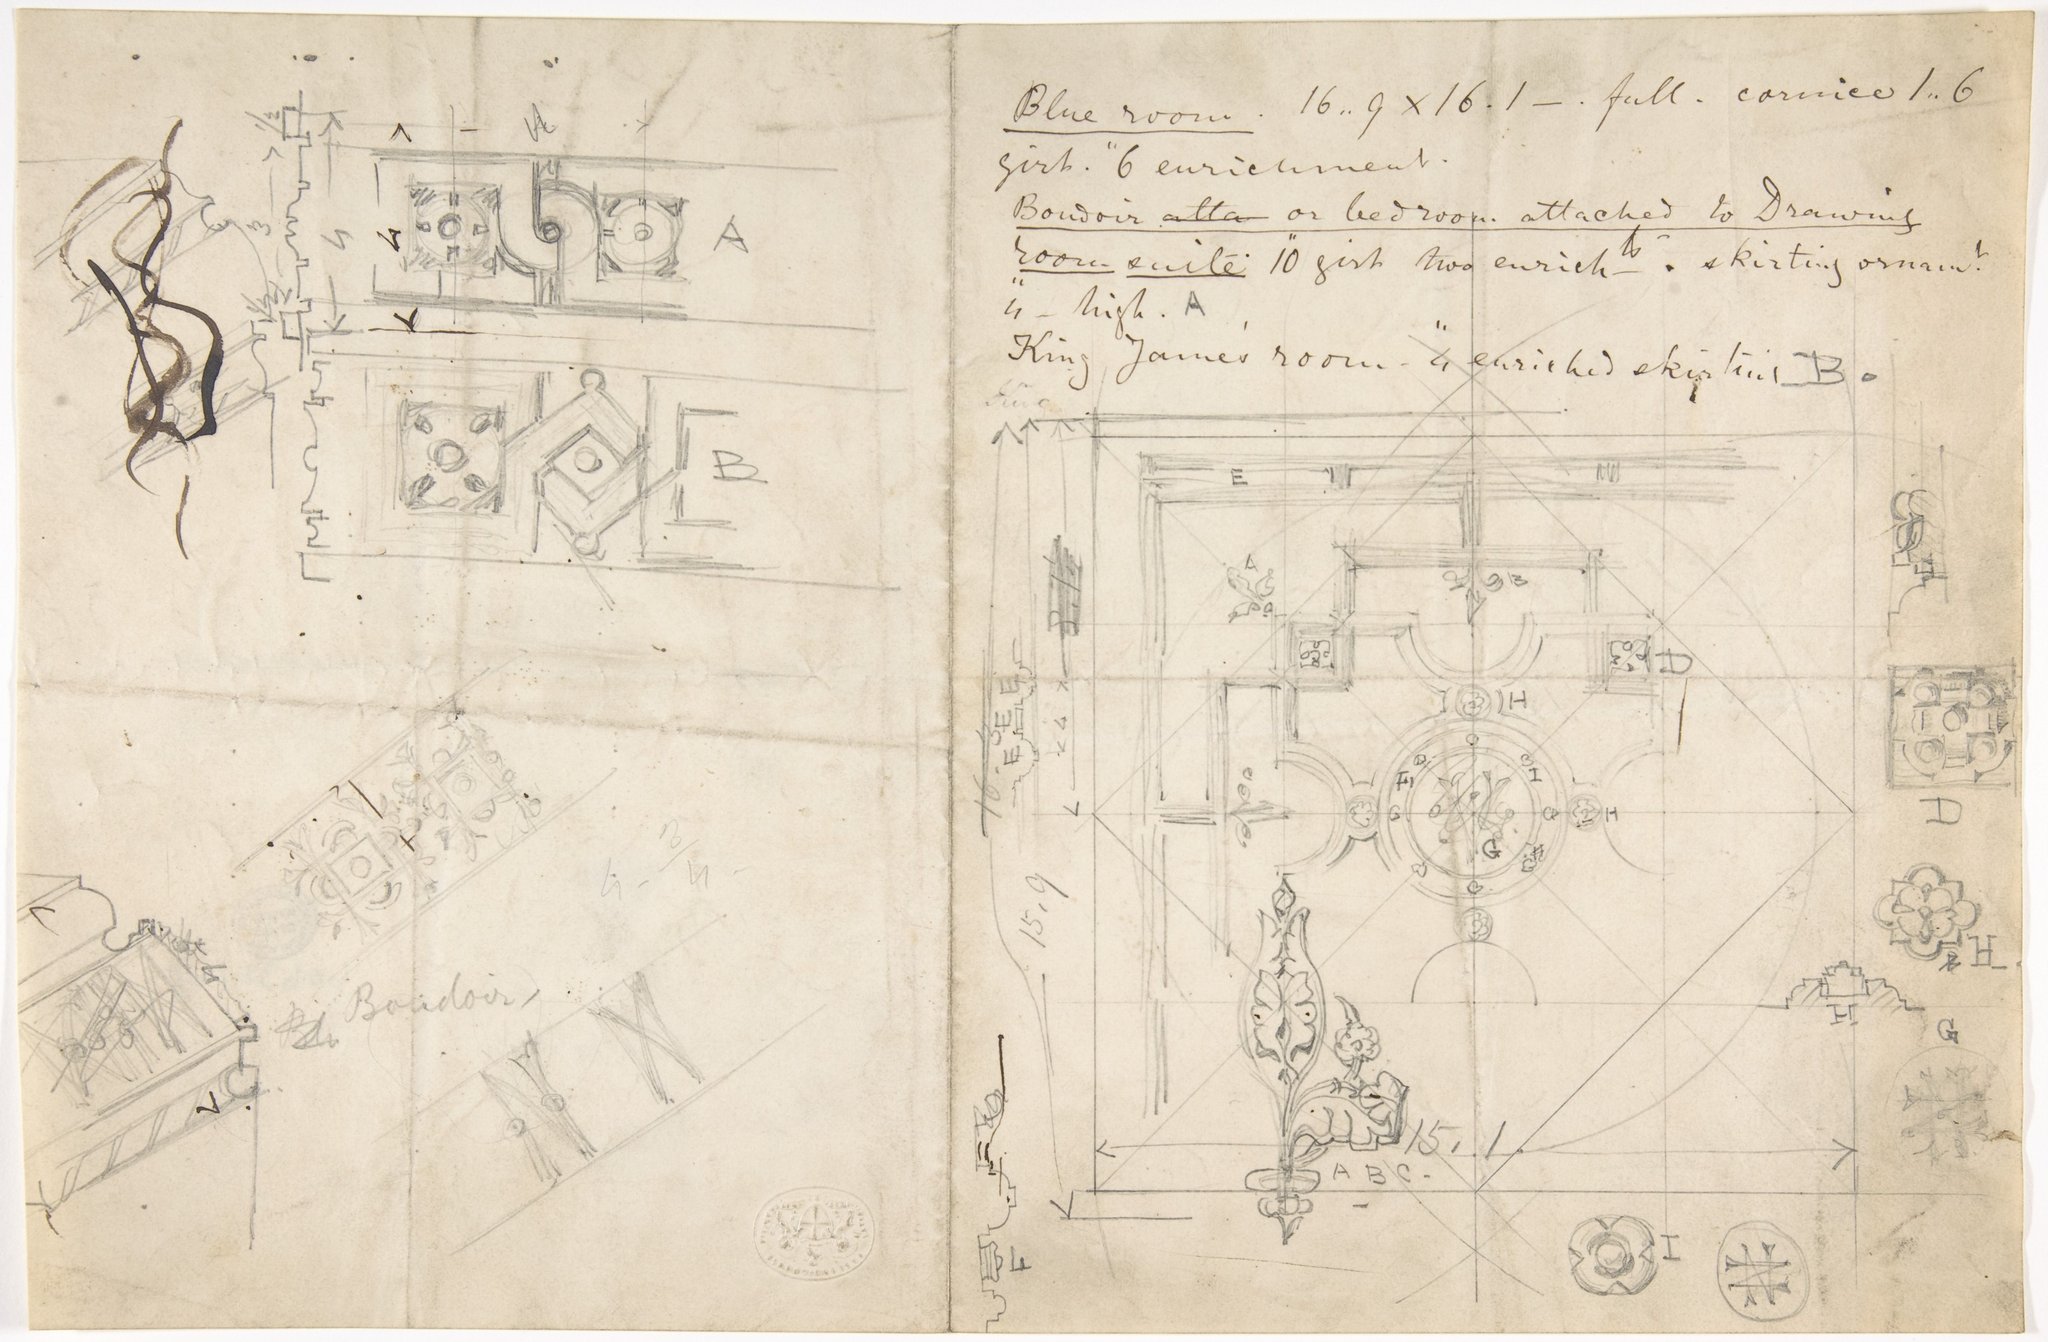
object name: drawing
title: Paneled Ceiling Design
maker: anonymous, british, 19th century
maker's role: artist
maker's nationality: british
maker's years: 1800-1900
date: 1851-1900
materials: graphite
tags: architecture,ceilings